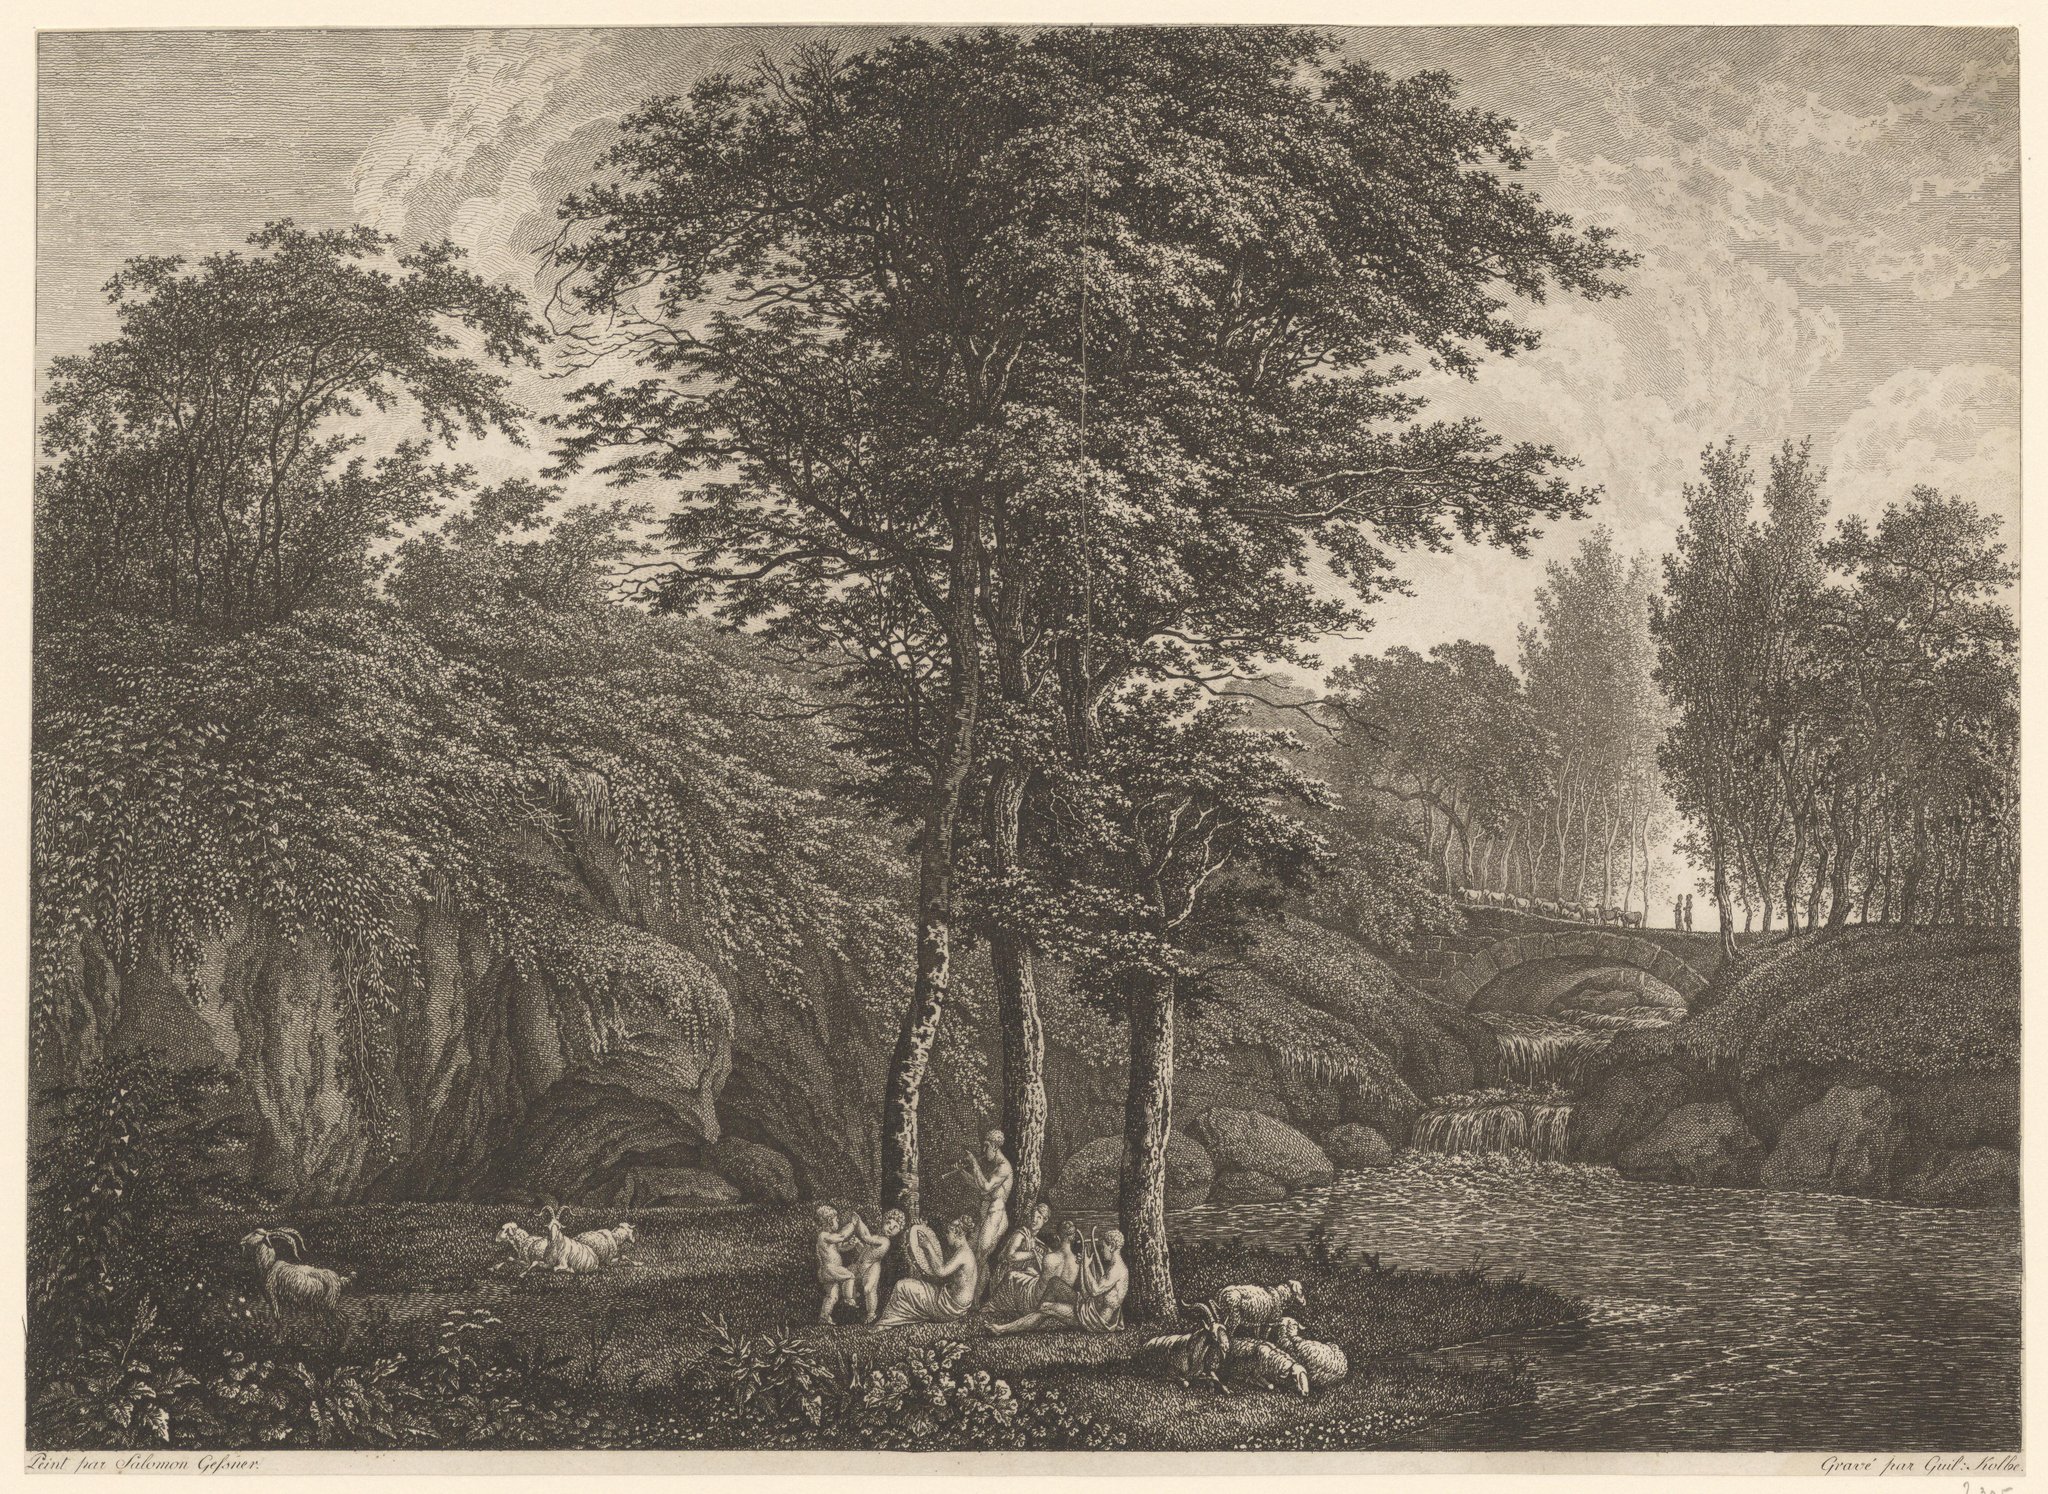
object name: print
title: Rotachtig landschap met dansende en musicerende nimfen bij watervallen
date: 1805-1811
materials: paper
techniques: etching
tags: herding, herdsman, herdswoman, shepherd, shepherdess, cowherd, etc., waterfall, landscape with bridge, viaduct or aqueduct, (traveller) resting in the open air, private festivities, merry company - aa - in the open air, 'fête champêtre', pastorals, arcadian scenes, evening ~ landscape (sometimes titled 'vesper')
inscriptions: collector's mark: Lugt 2228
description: Deze prent is gemaakt voor een serie uit 1811 getiteld: Collection des tableaux en gouache et des dessins de Salomon Gessner. Gravés à l'eau forte par Guil. Kolbe. De gehele serie is in het bezit van het RMA onder inv. nr. RP-P-2005-184.